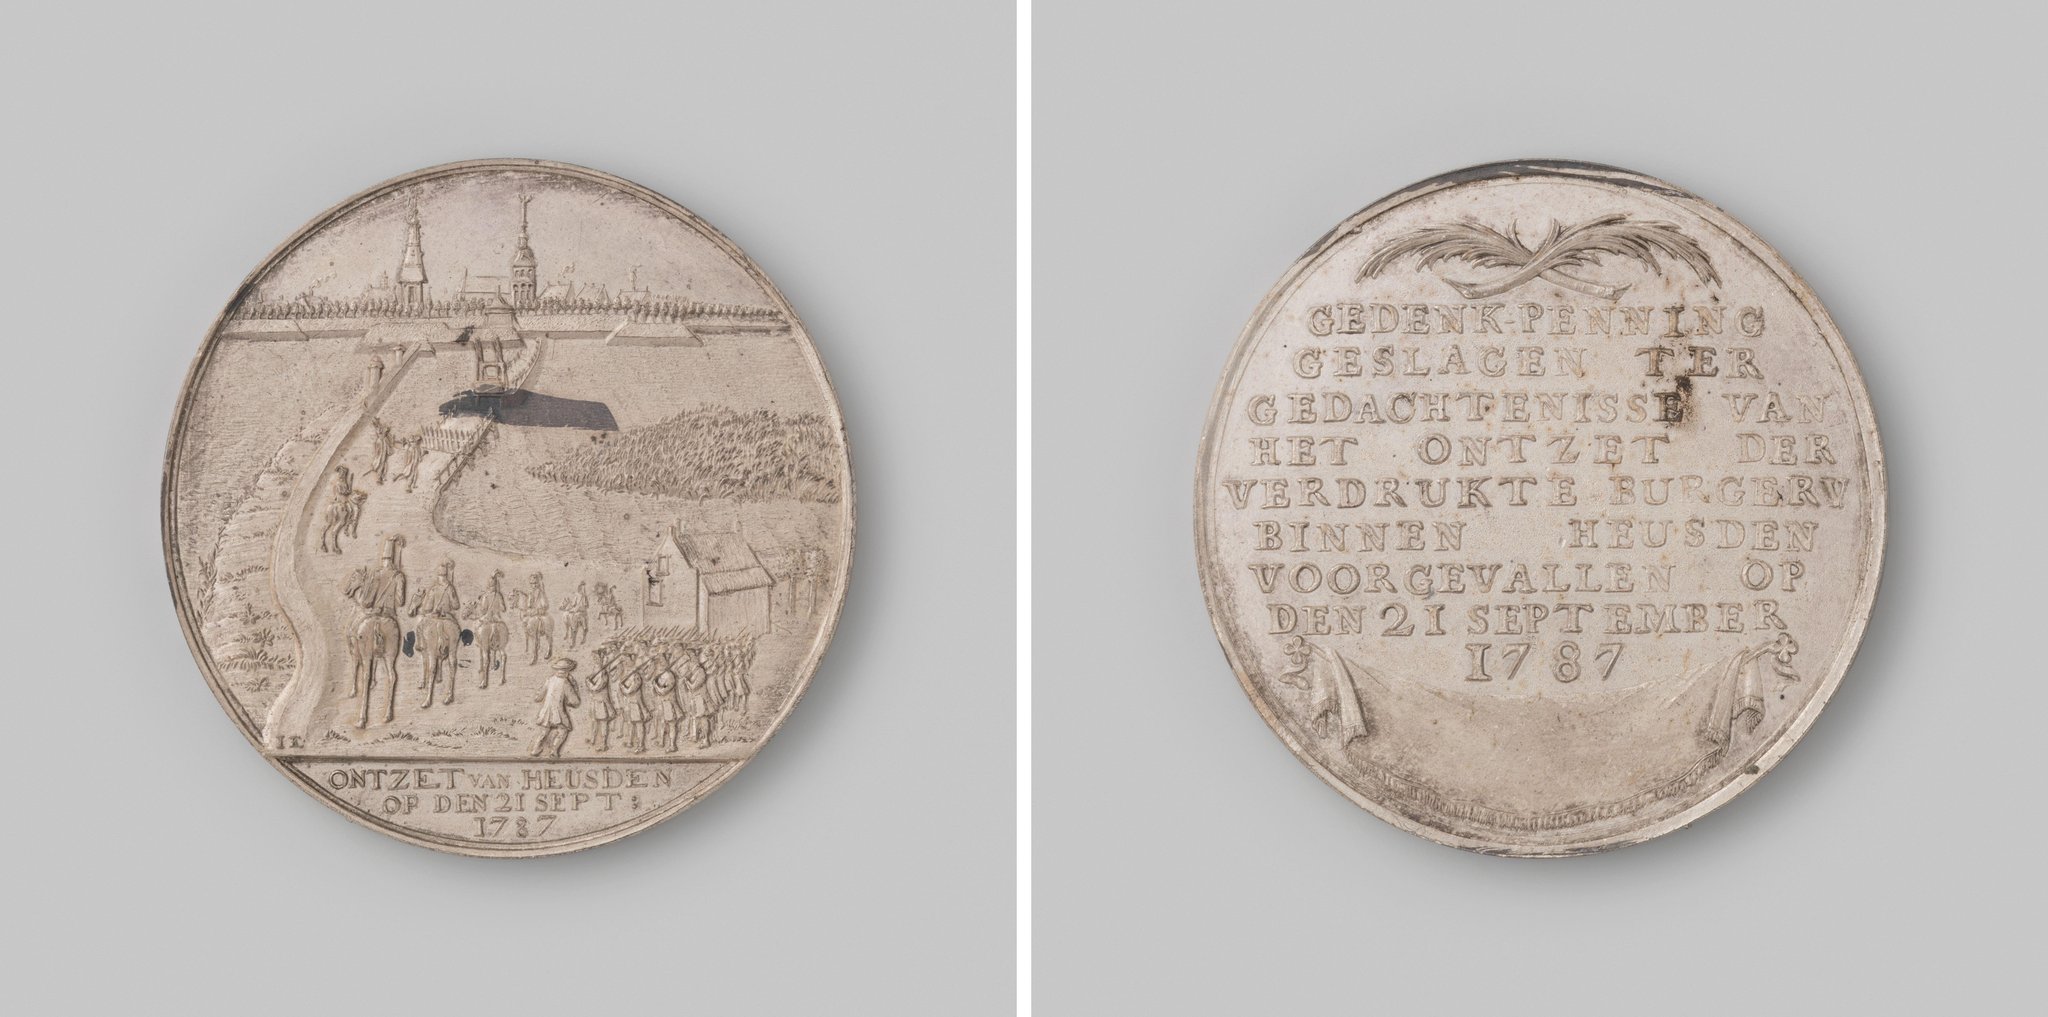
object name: history medal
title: Ontzet van Heusden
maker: Anonymous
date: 1787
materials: silver